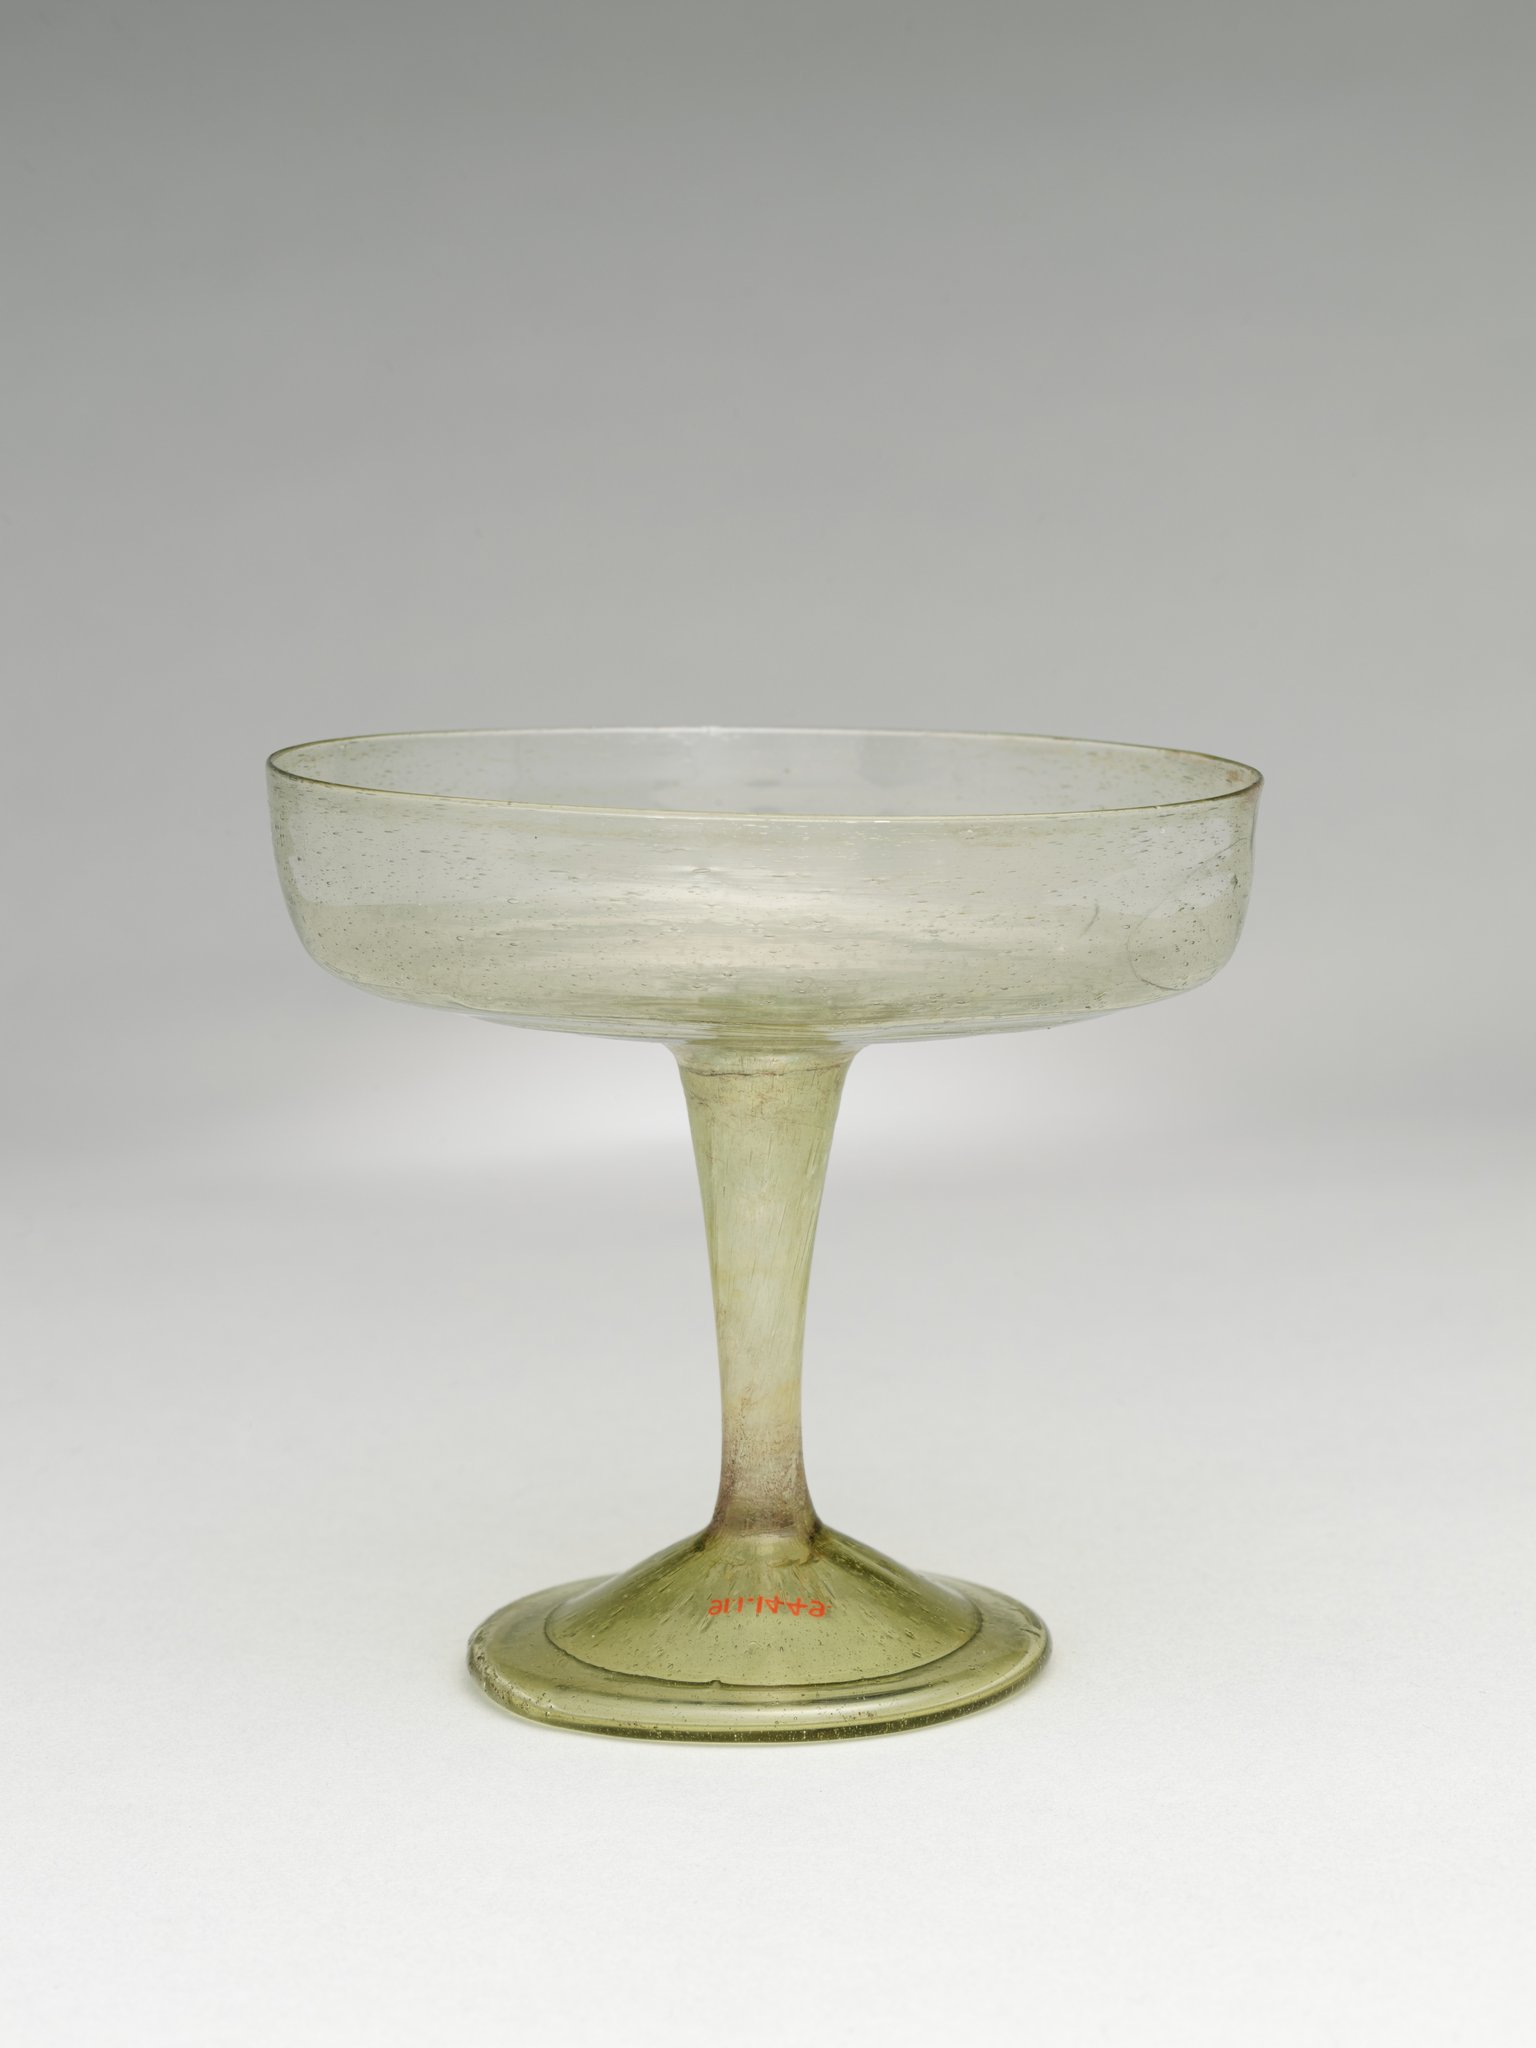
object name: tazza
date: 1601-1700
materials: glass